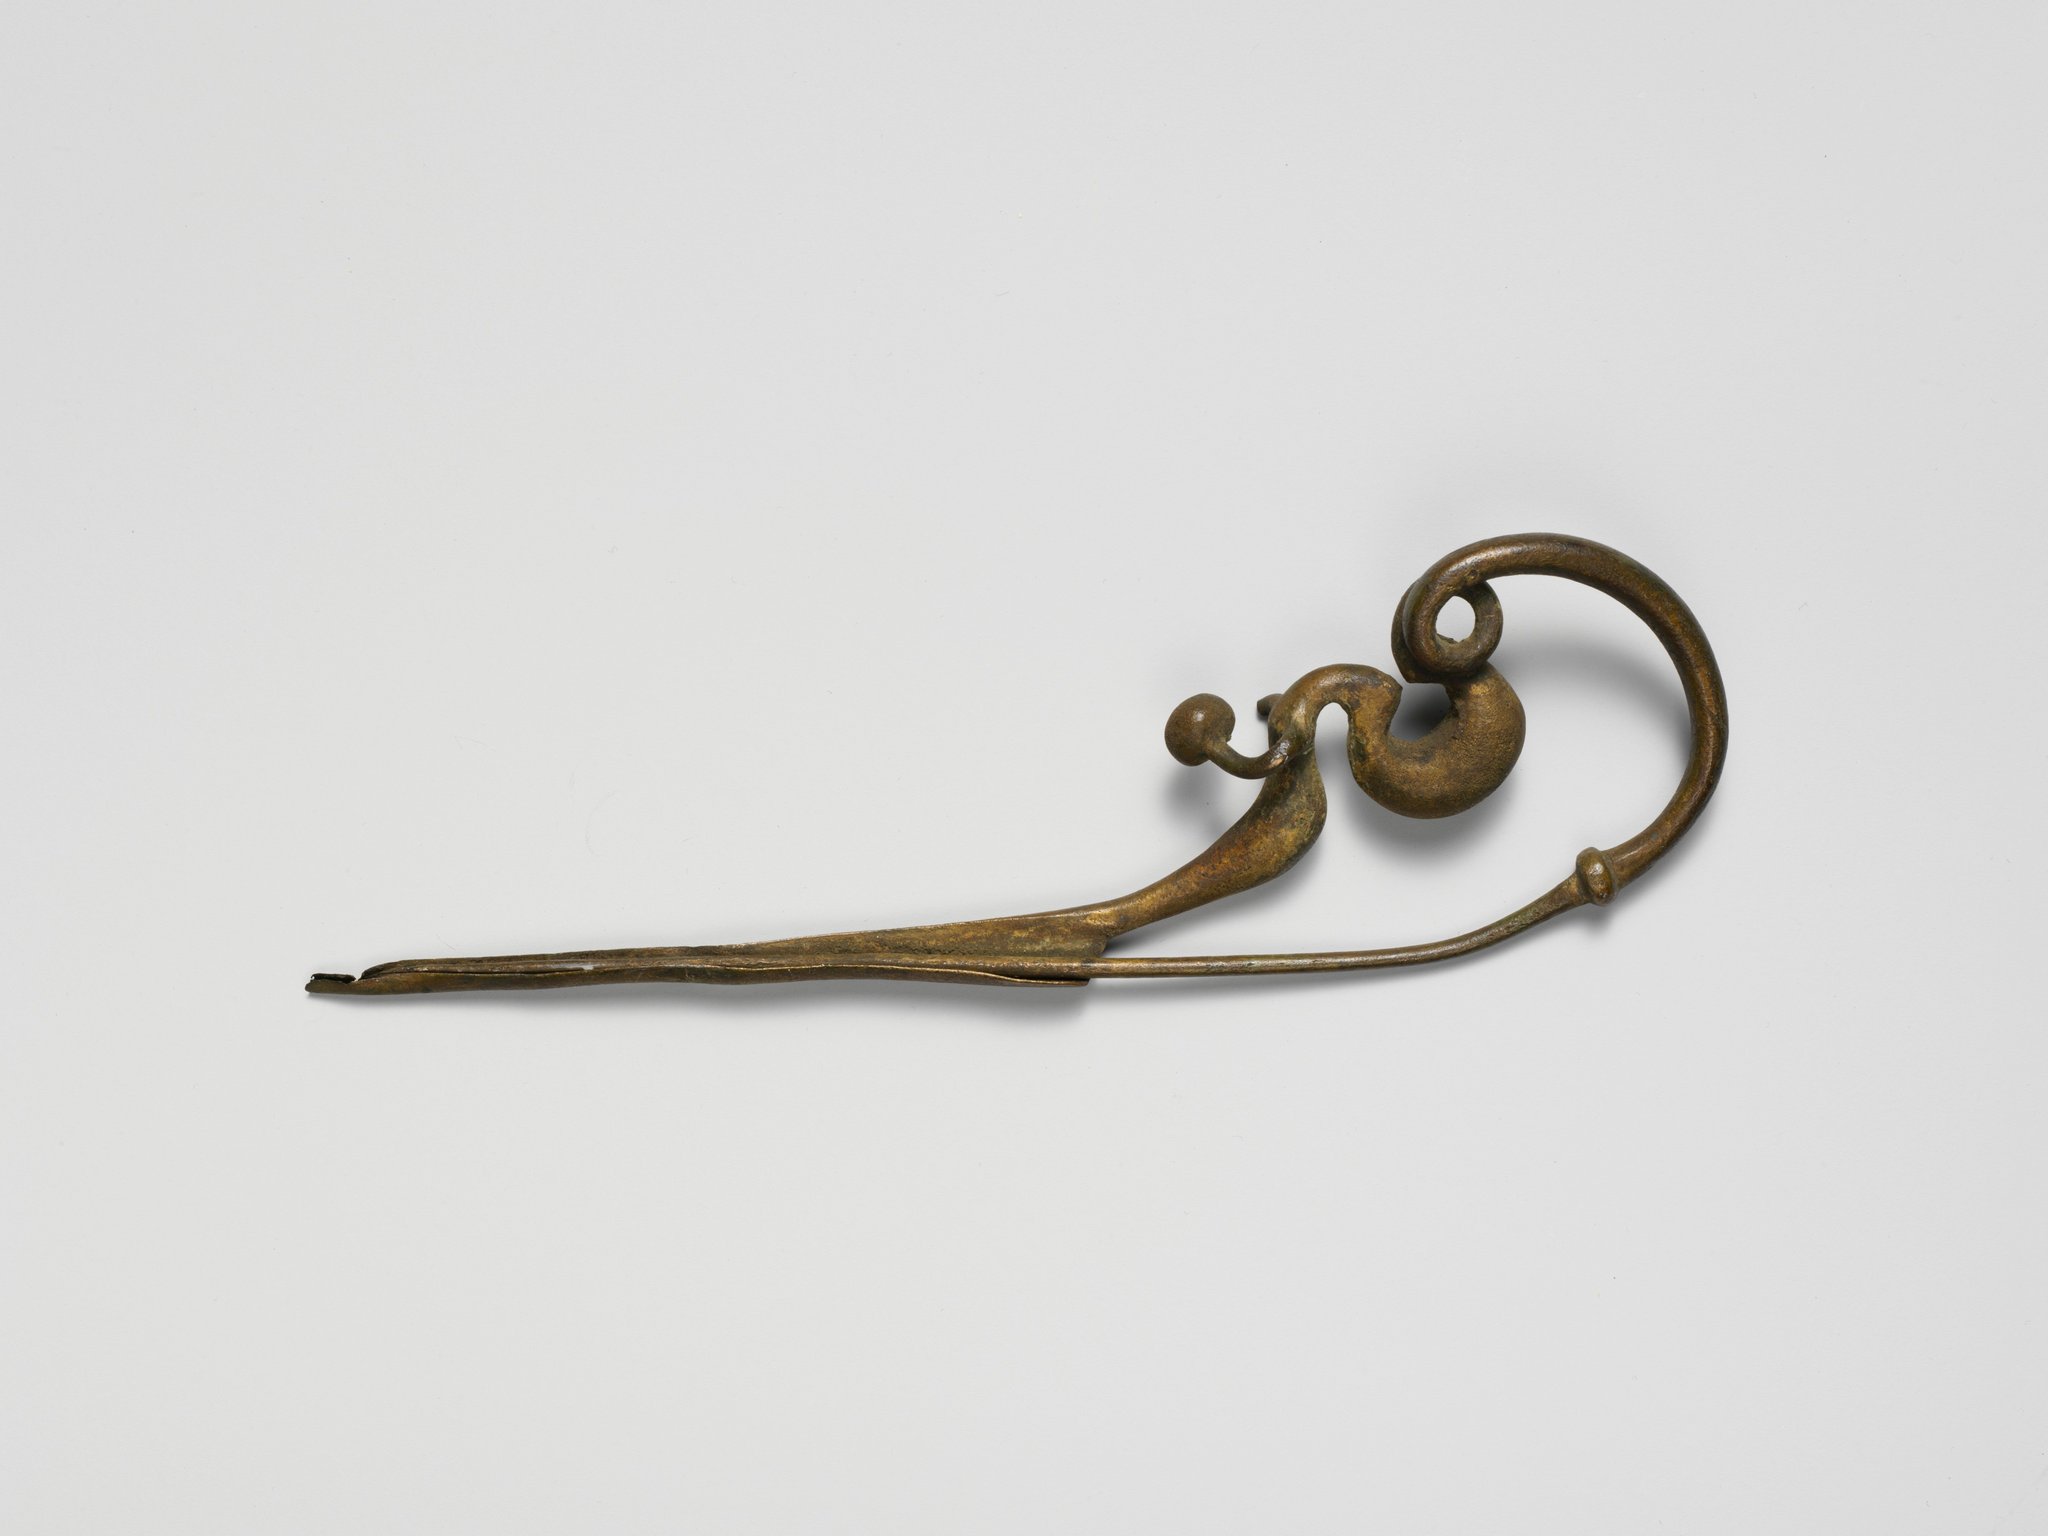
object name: fibula, dragon type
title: Bronze dragon-type fibula (safety pin)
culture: early etruscan or late villanovan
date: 700-650 BCE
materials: bronze